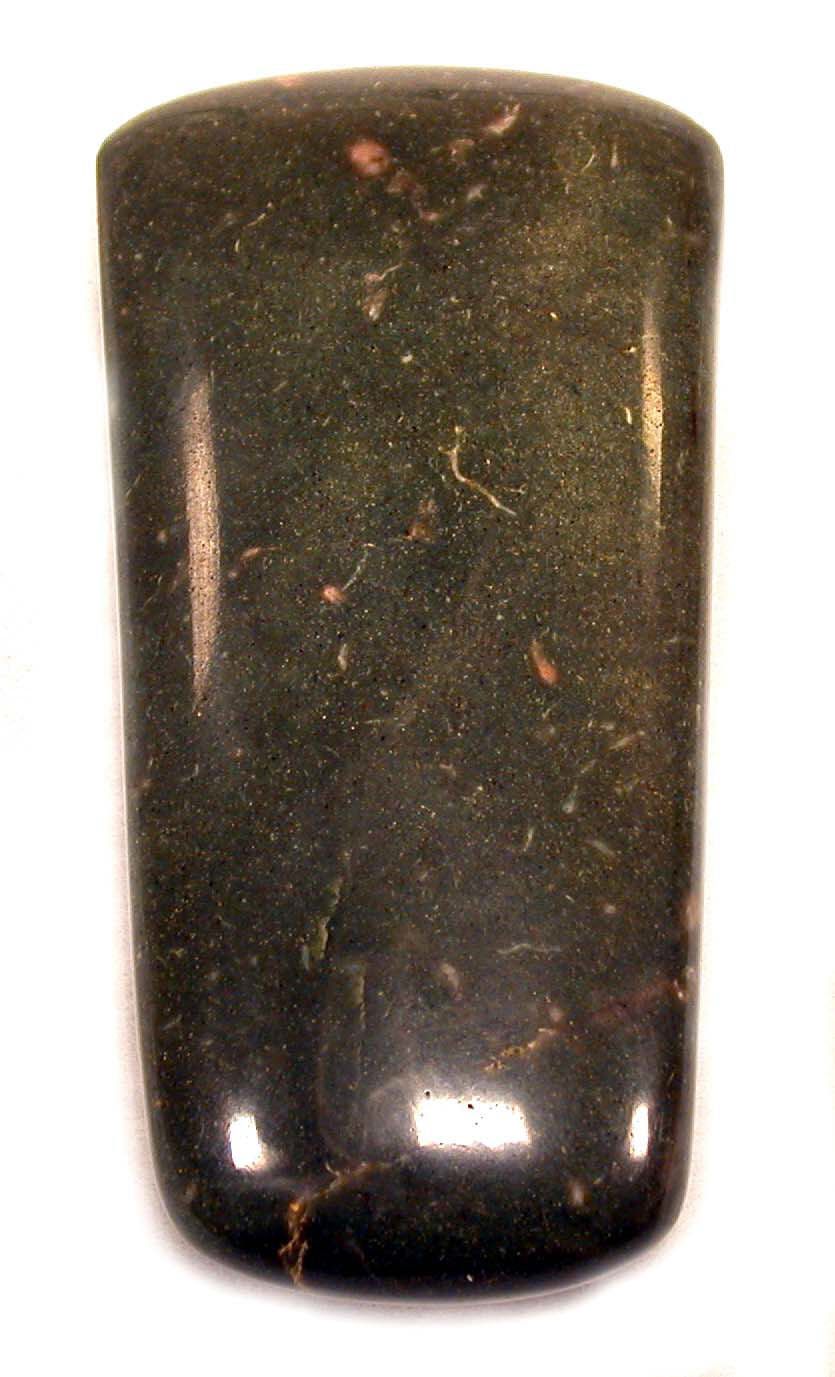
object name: celt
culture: mexican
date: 1501-1600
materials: stone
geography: mexico